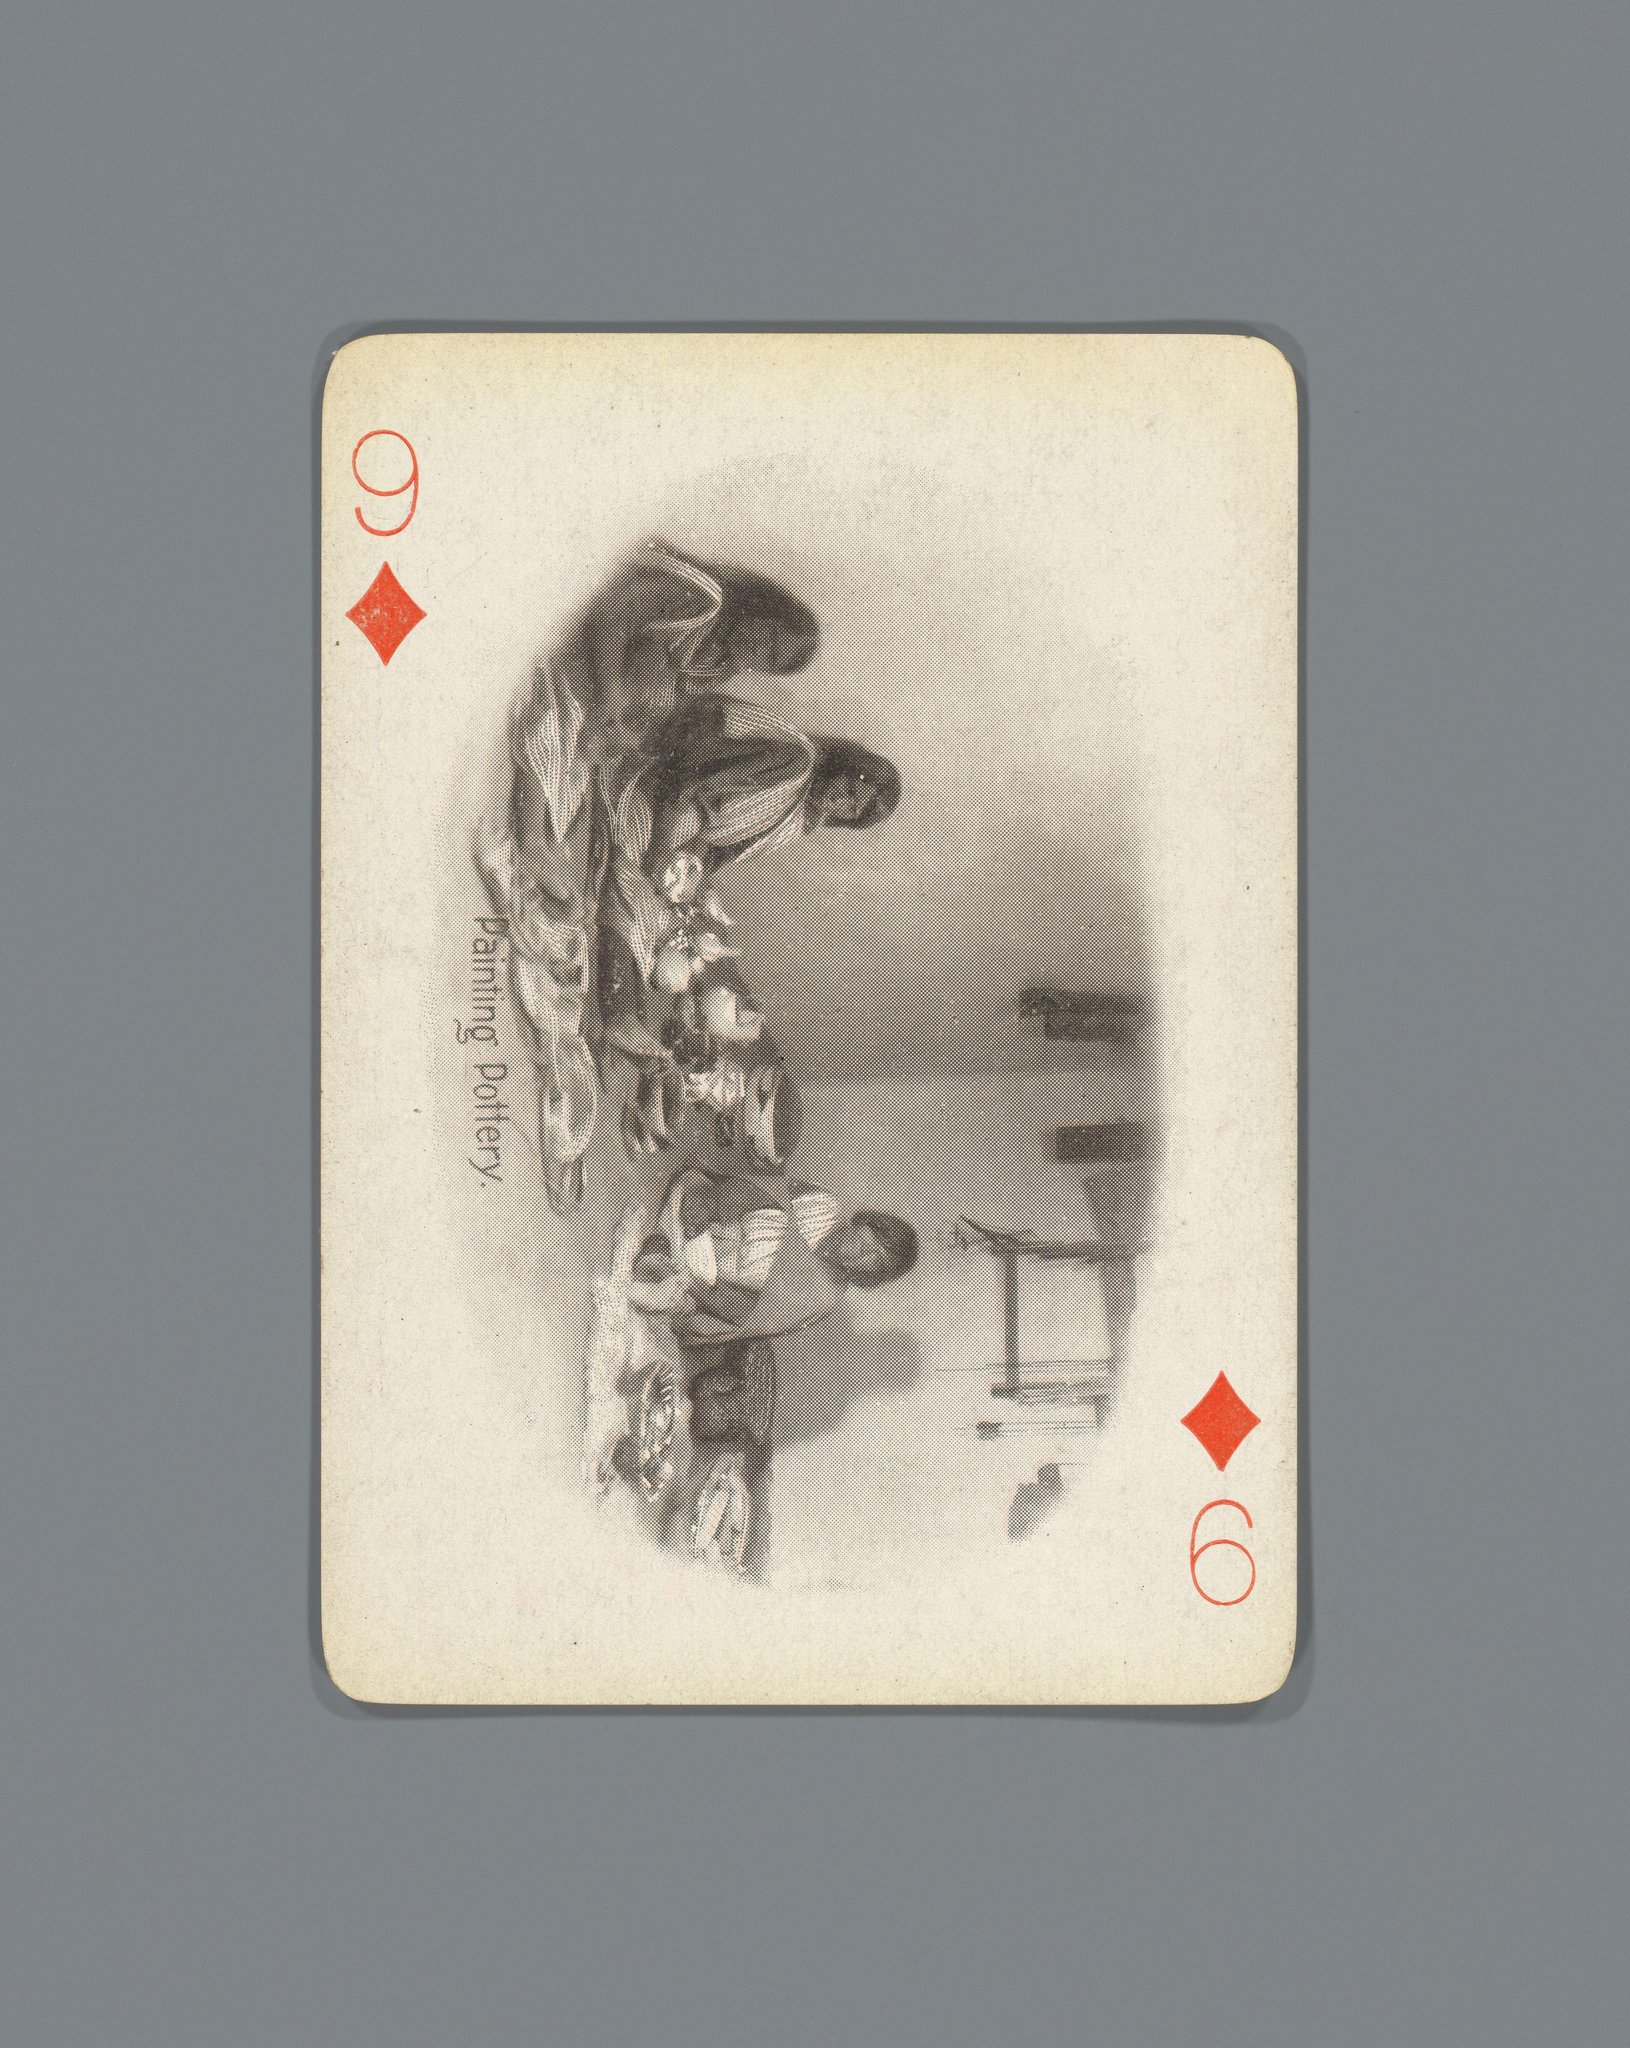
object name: photograph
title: Painting Pottery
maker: adam clark vroman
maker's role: fotograaf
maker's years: 1856-1916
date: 1900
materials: paper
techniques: autotype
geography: los angeles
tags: united states of america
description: Speelkaart uit doosje met 53 speelkaarten met afbeeldingen in autotypie van Native Americans. De inhoud bevat een complete set speelkaarten inclusief joker.